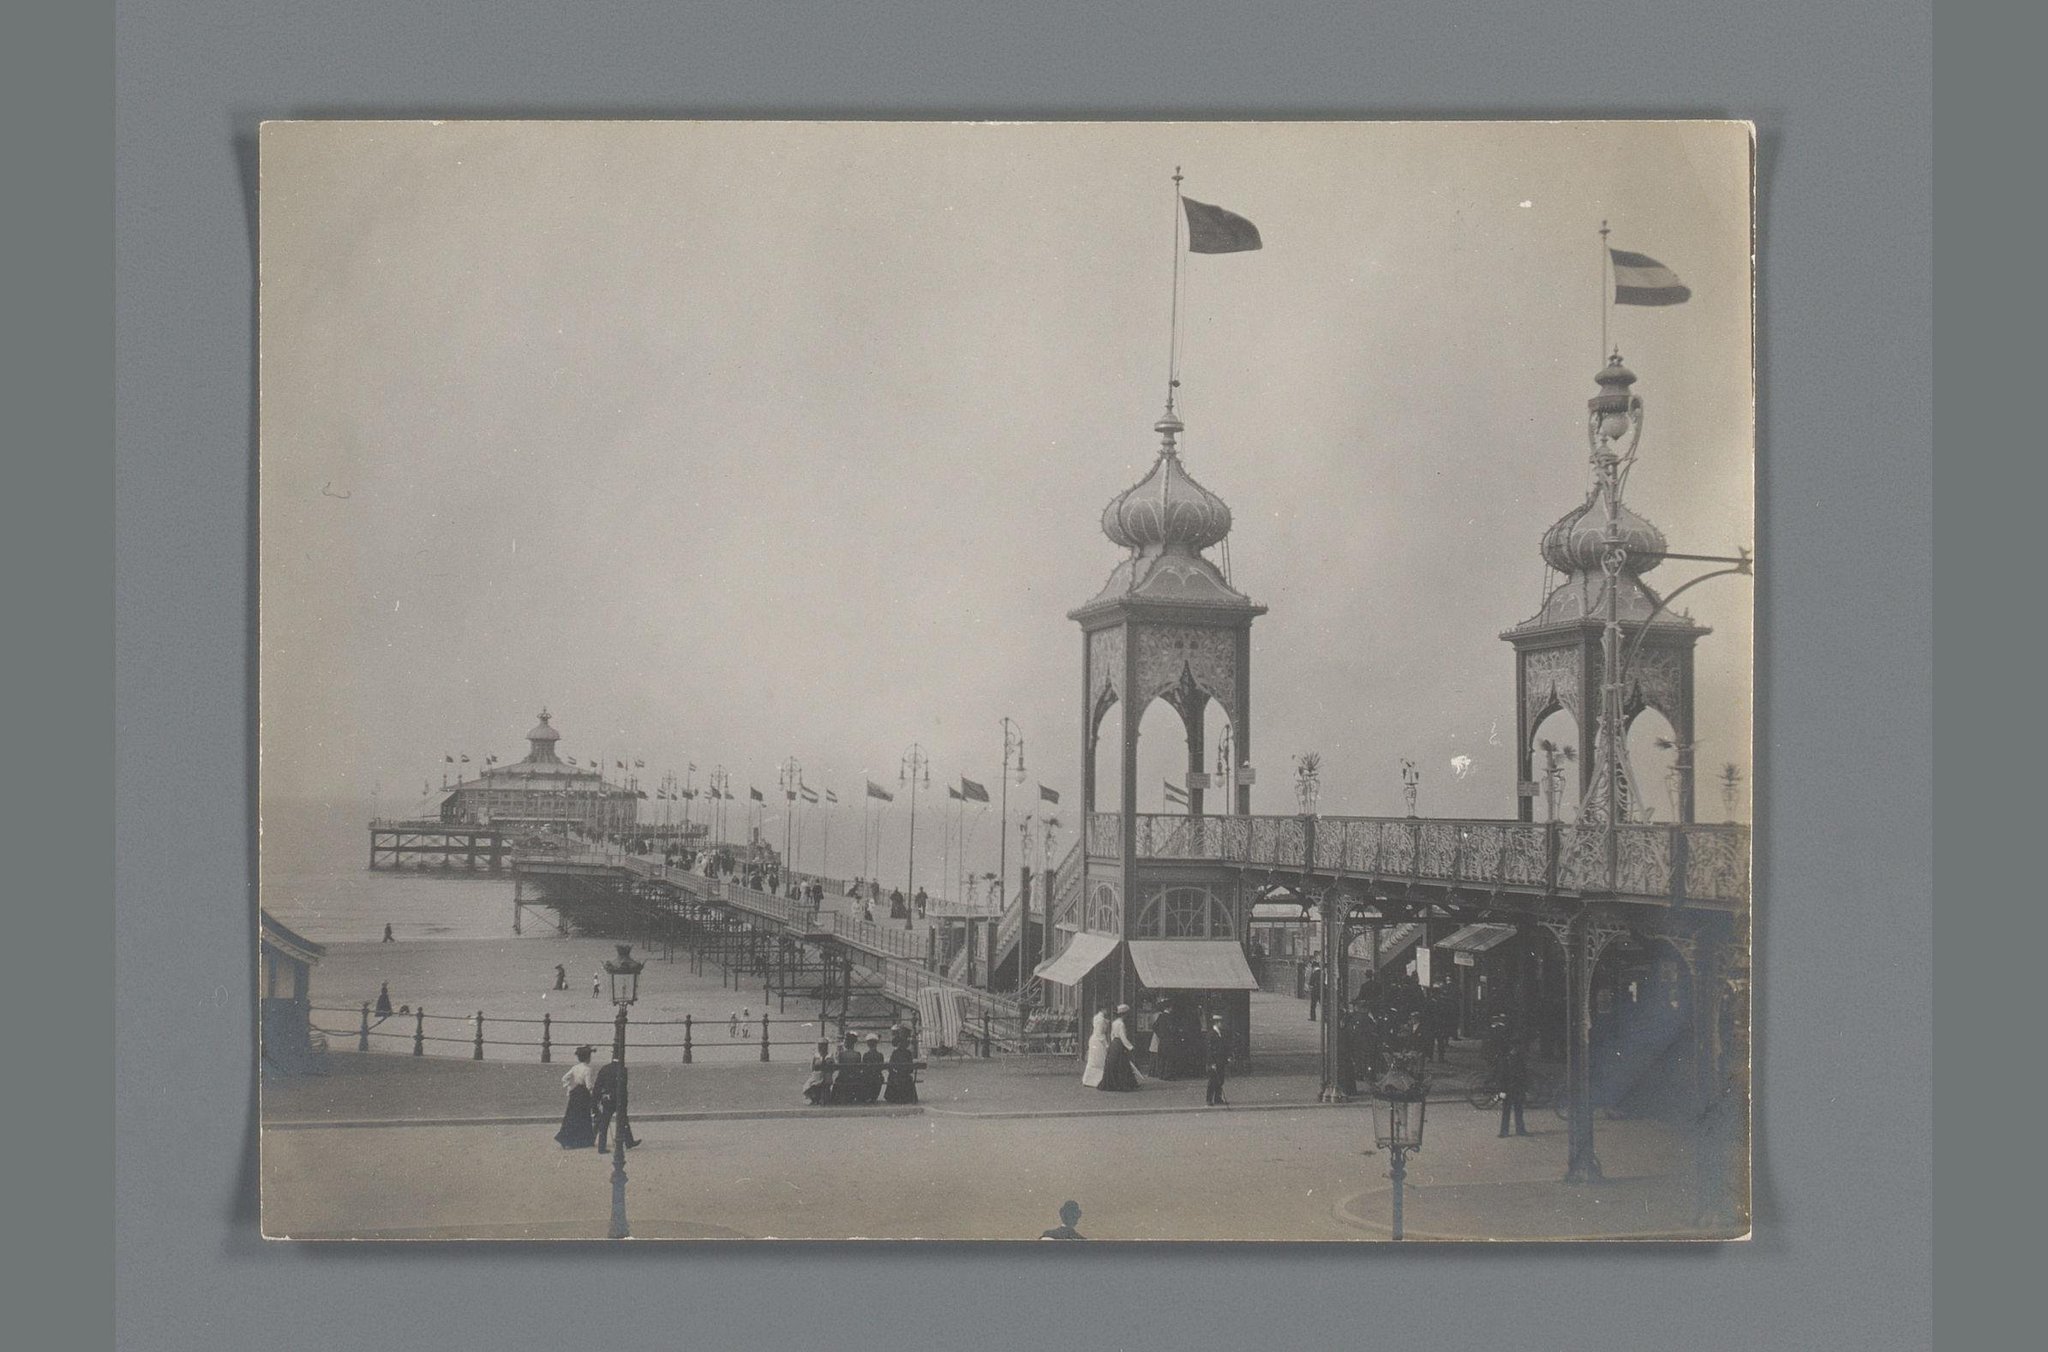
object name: photograph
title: Scheveningen strand met het wandelhoofd Wilhelmina en het paviljoen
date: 1901-1918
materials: paper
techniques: gelatin silver print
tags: pier, quay, wharf, coast